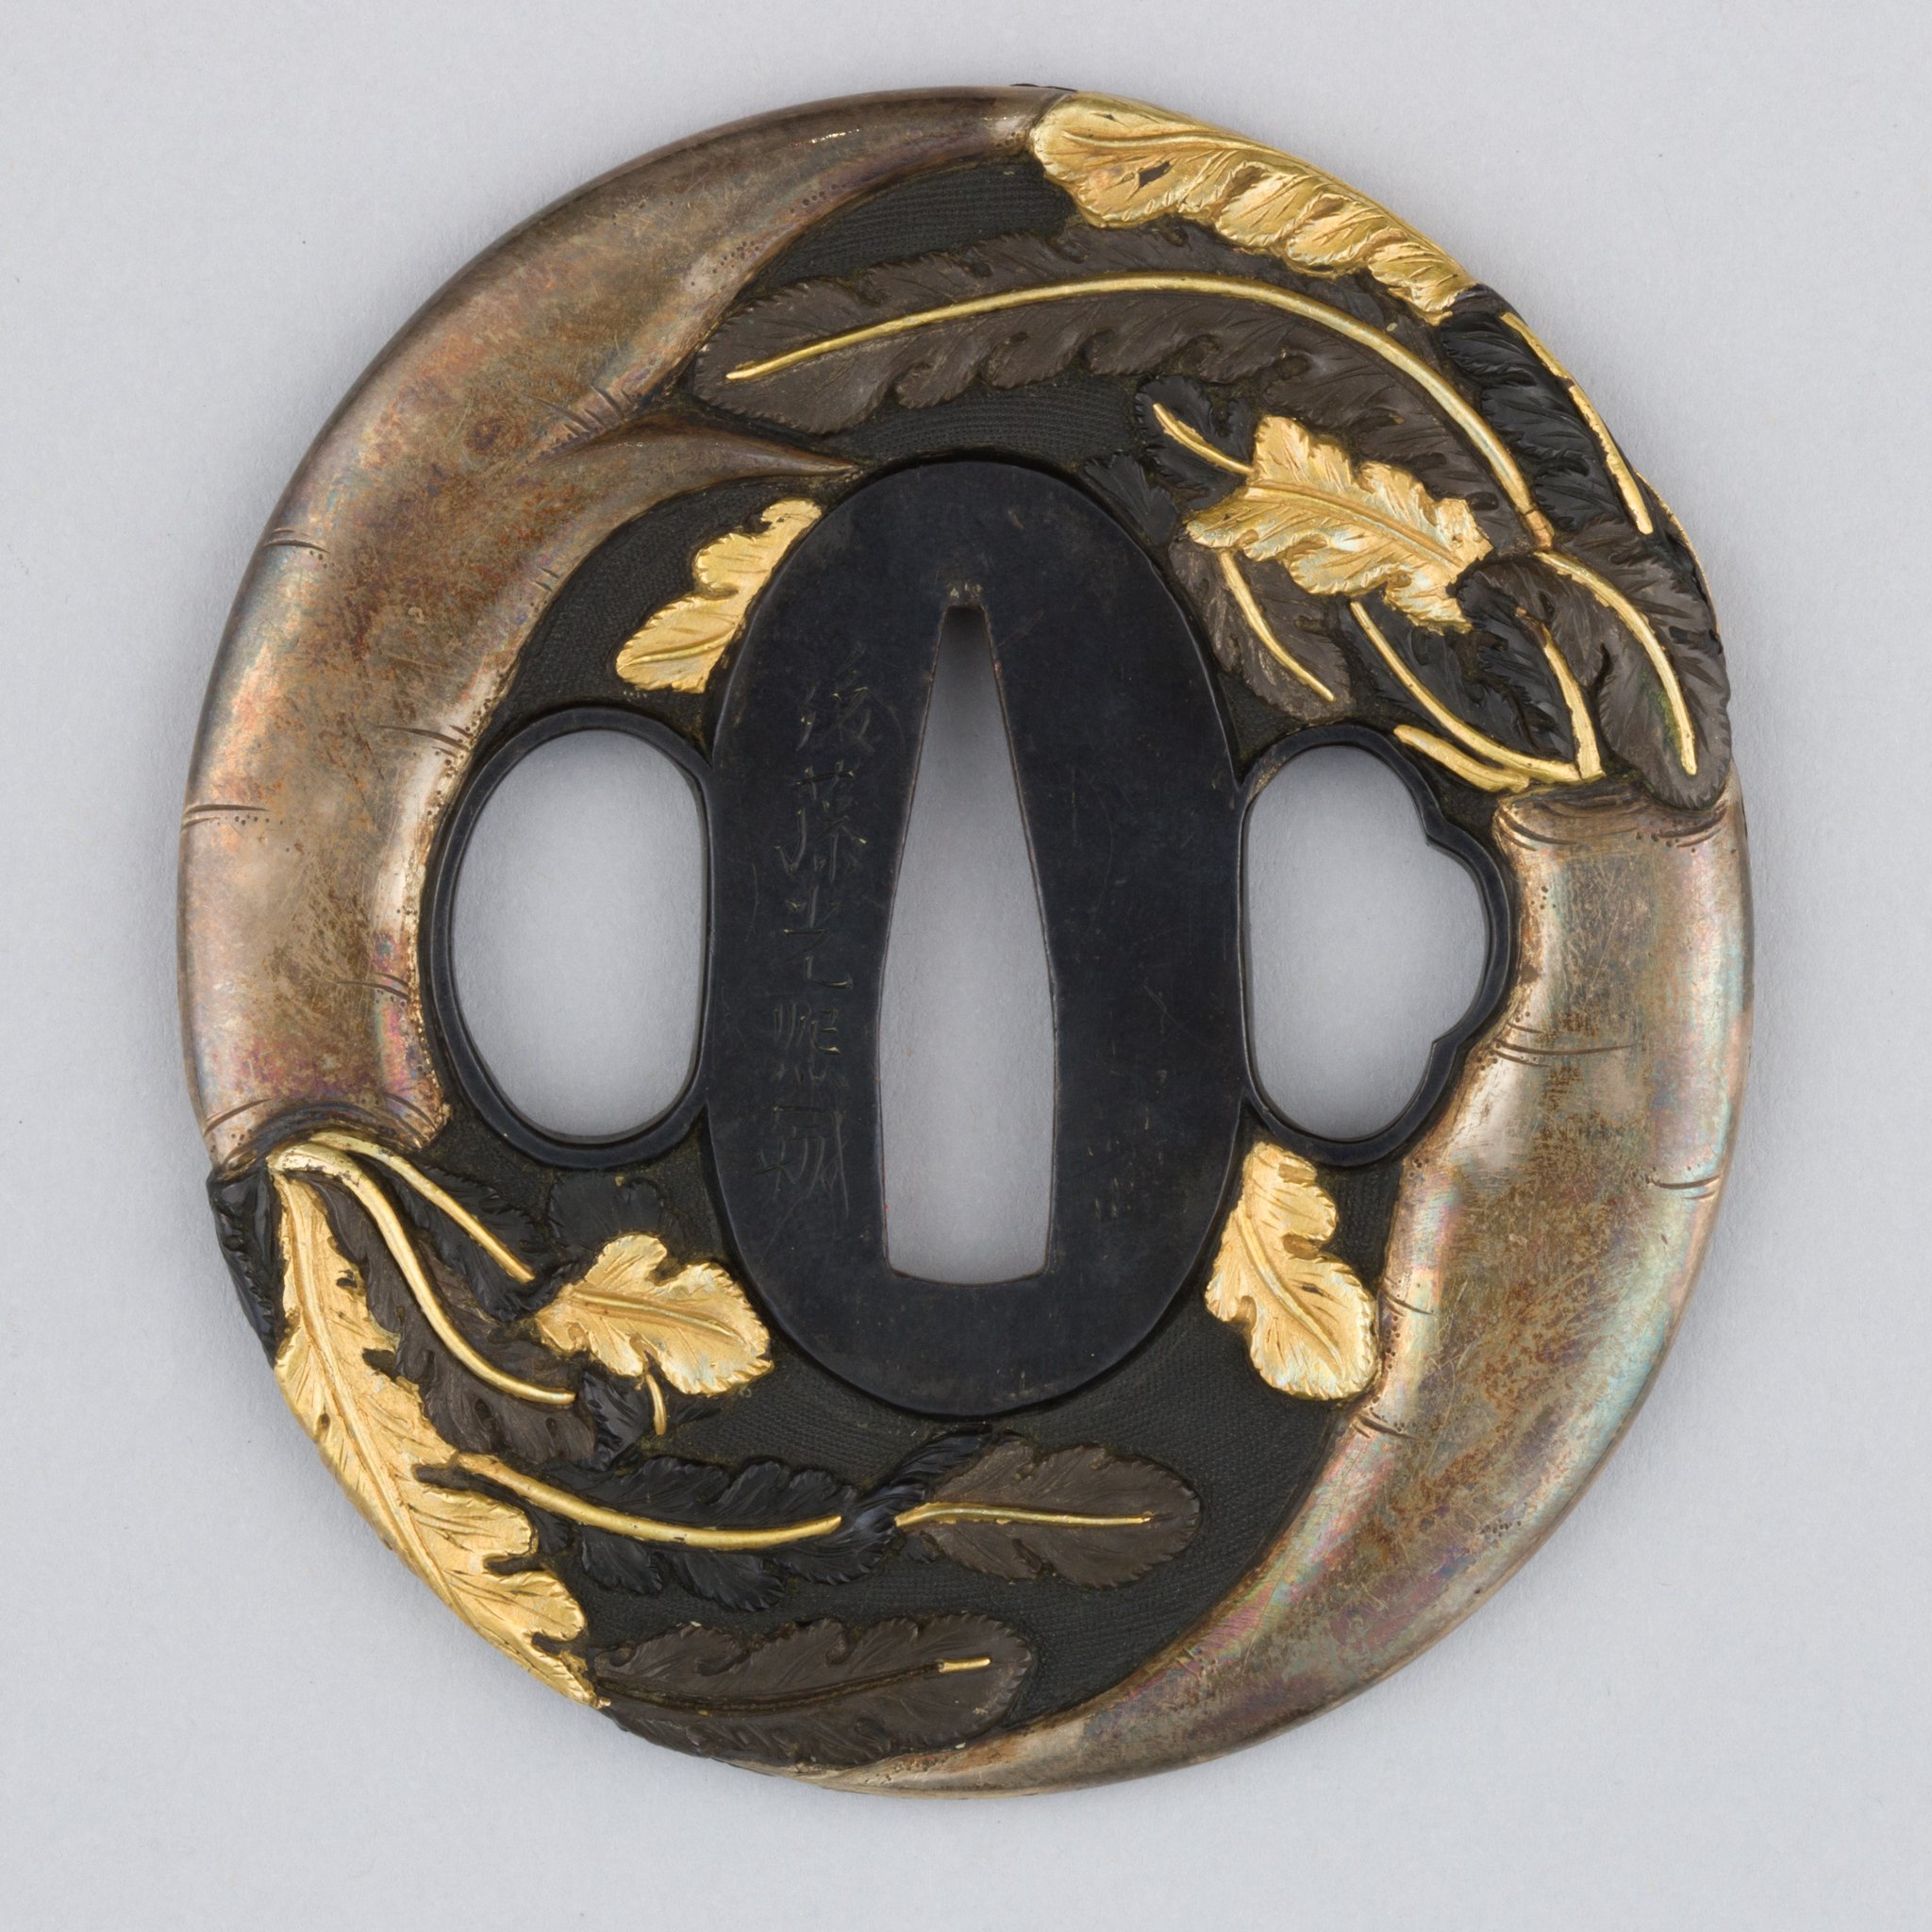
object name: sword guard tsuba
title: Sword Guard (Tsuba)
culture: japanese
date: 1615-1868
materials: copper, gold alloy, silver alloy, gold, silver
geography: japan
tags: vegetables